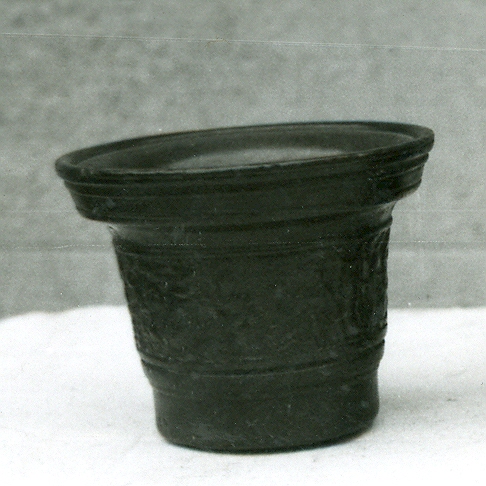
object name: mortar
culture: italian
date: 1801-1900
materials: copper alloy, patina